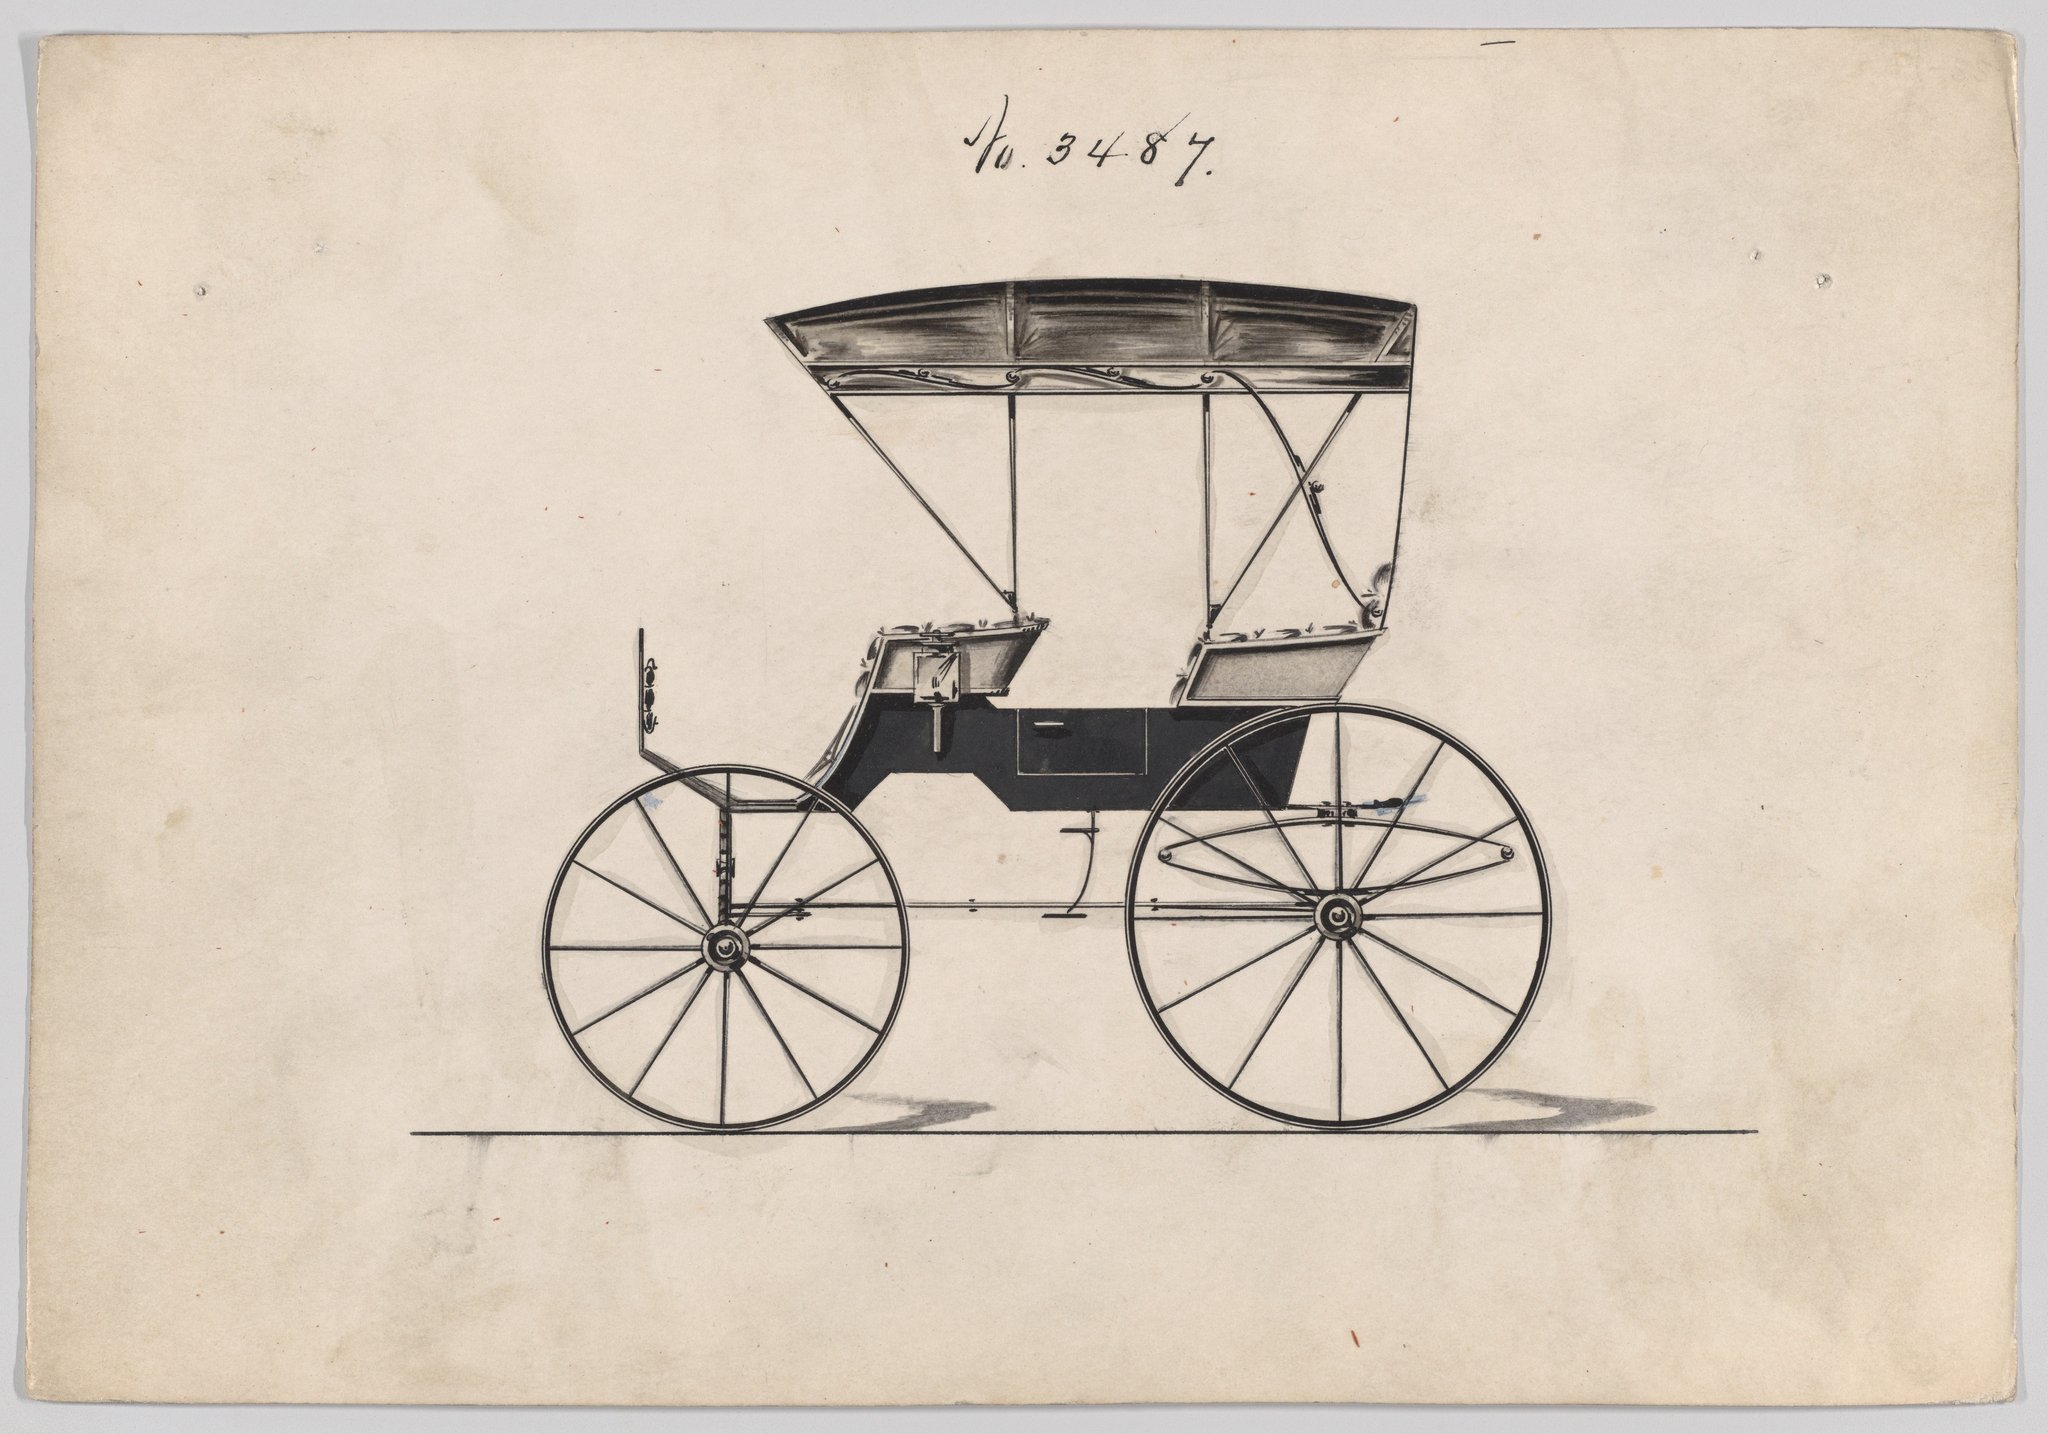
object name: drawing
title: Design for Extension Top Park Phaeton, no. 3487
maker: brewster & co.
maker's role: manufacturer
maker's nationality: american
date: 1879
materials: gouache, gum arabic, ink, watercolor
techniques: pen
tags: carriages